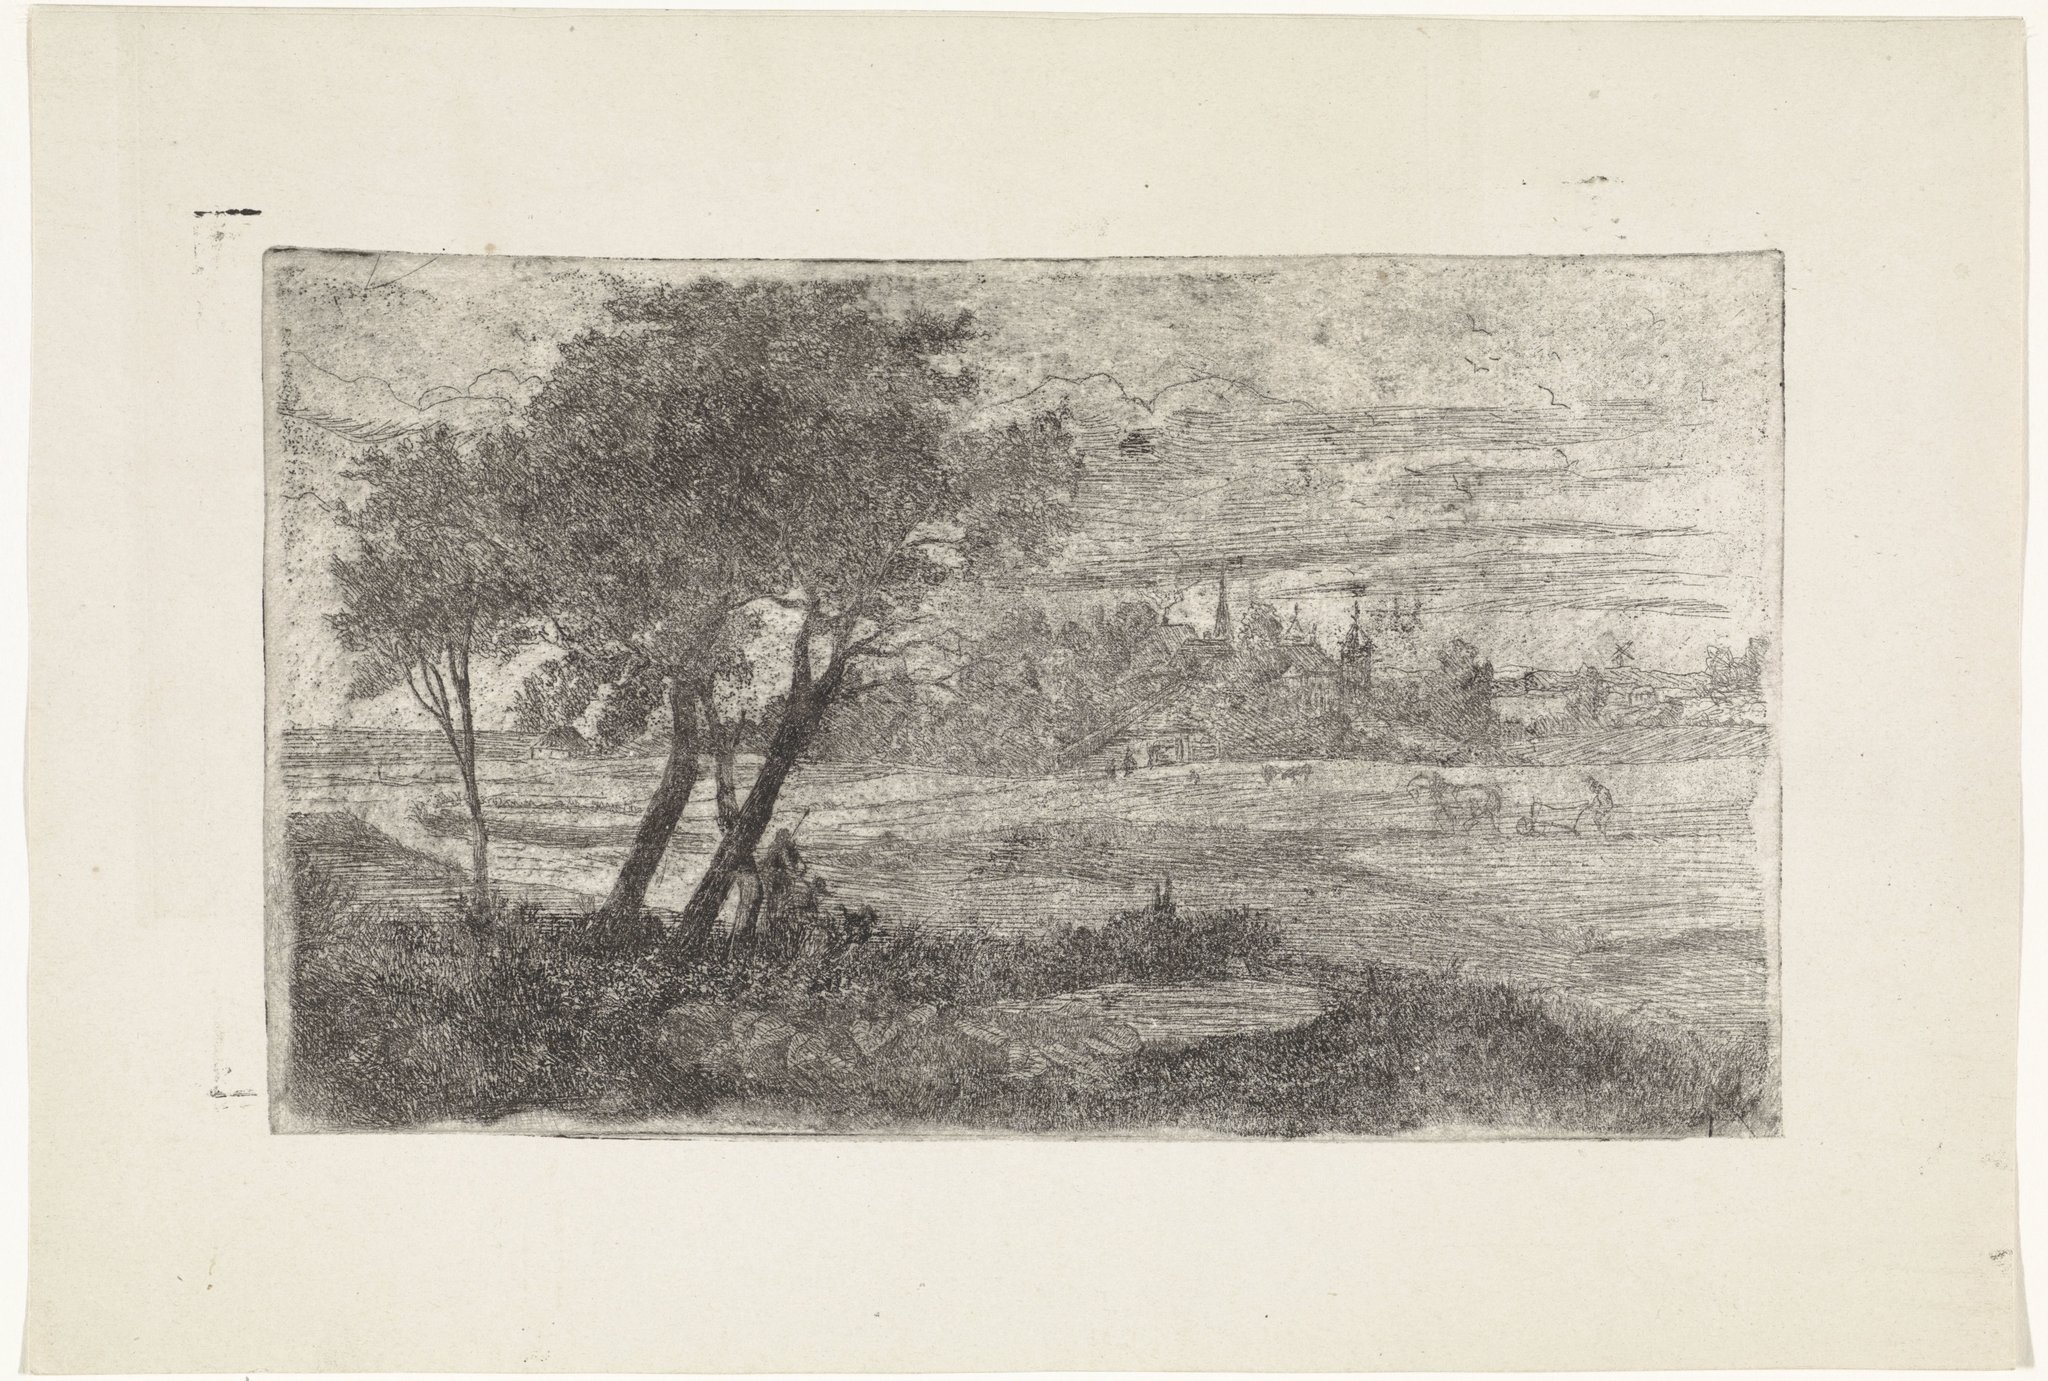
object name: print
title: Landschap met bomen op de voorgrond en een ploeg op de akker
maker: dirk arnoldus tavenraat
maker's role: draughtsman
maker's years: 1845-1930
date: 1855-1881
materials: paper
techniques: etching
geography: rotterdam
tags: trees, village, agricultural implements: plough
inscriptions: collector's mark: Lugt 2228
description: Landschap met links op de voorgrond bomen. Daarachter een akker met een ploeg en geheel op de achtergrond een heuvel met een dorp.